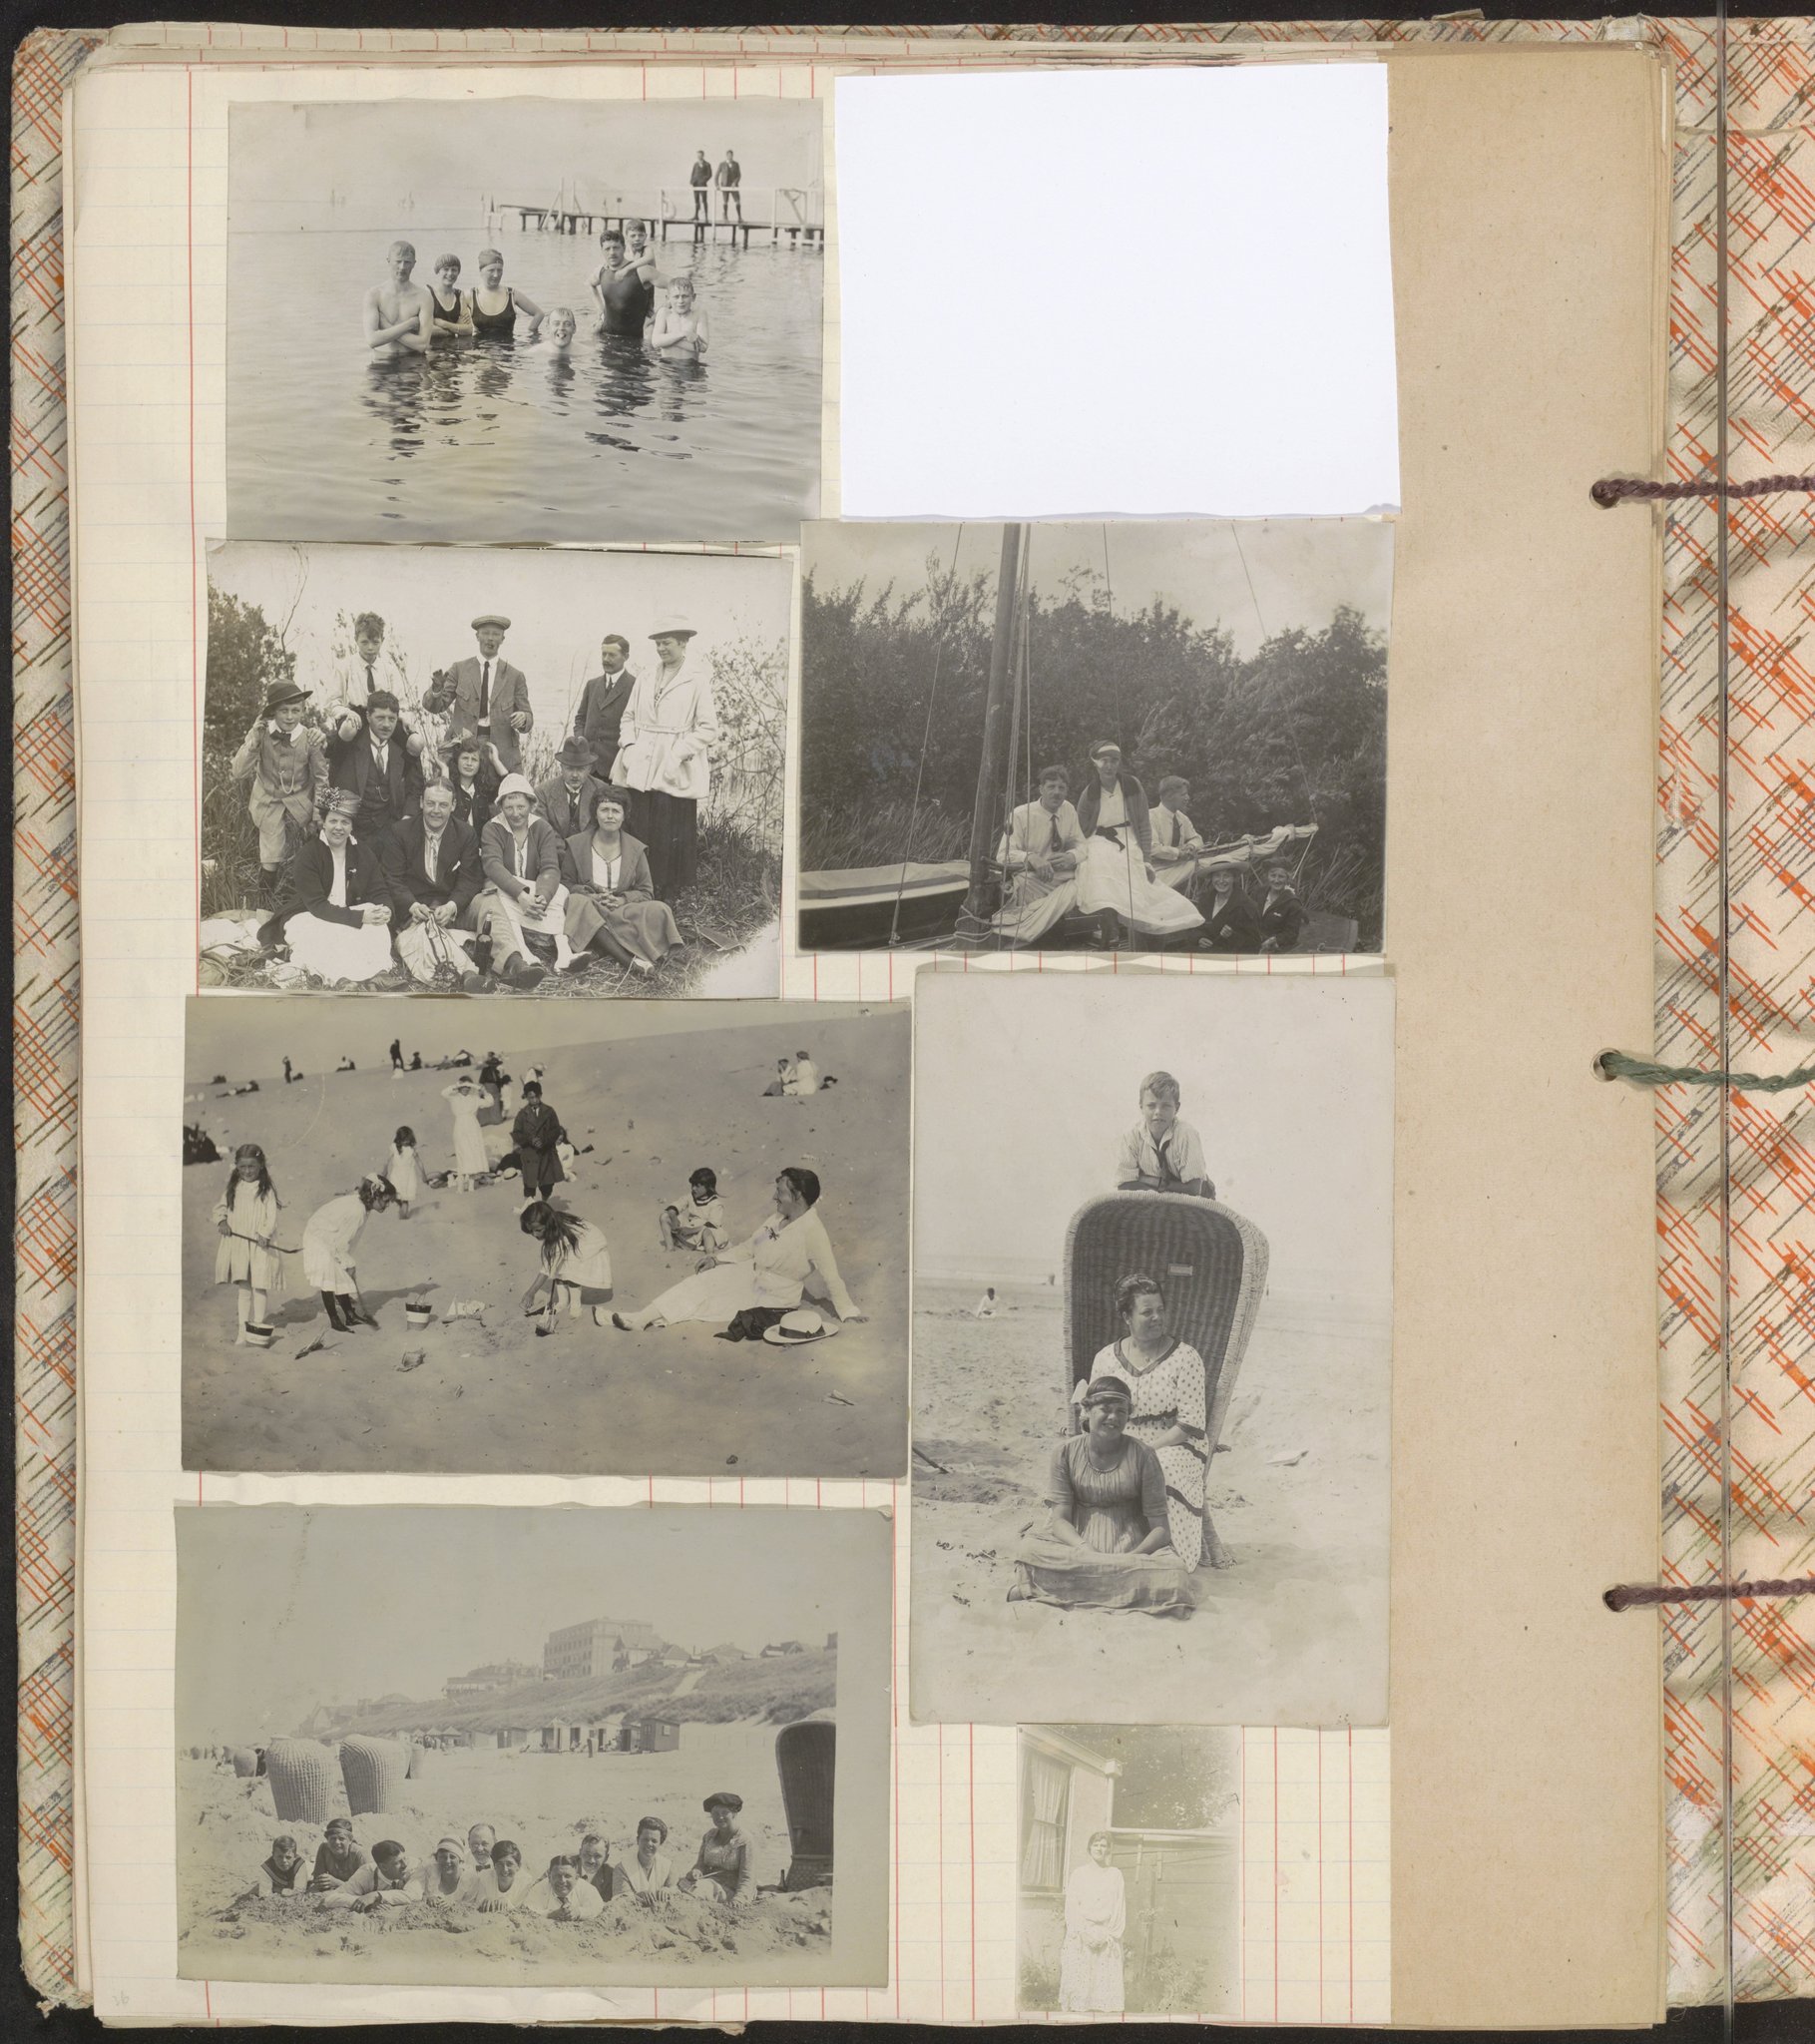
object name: photograph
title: Groepsportretten van onbekende personen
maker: Anonymous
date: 1910-1930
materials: paper, photographic support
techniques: gelatin silver print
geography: netherlands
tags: beach (as place of recreation), adult woman, adult man, child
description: Albumblad met groepsportretten van volwassenen en kinderen, voornamelijk aan zee. Onderdeel van Fotoalbum van de familie Petri.